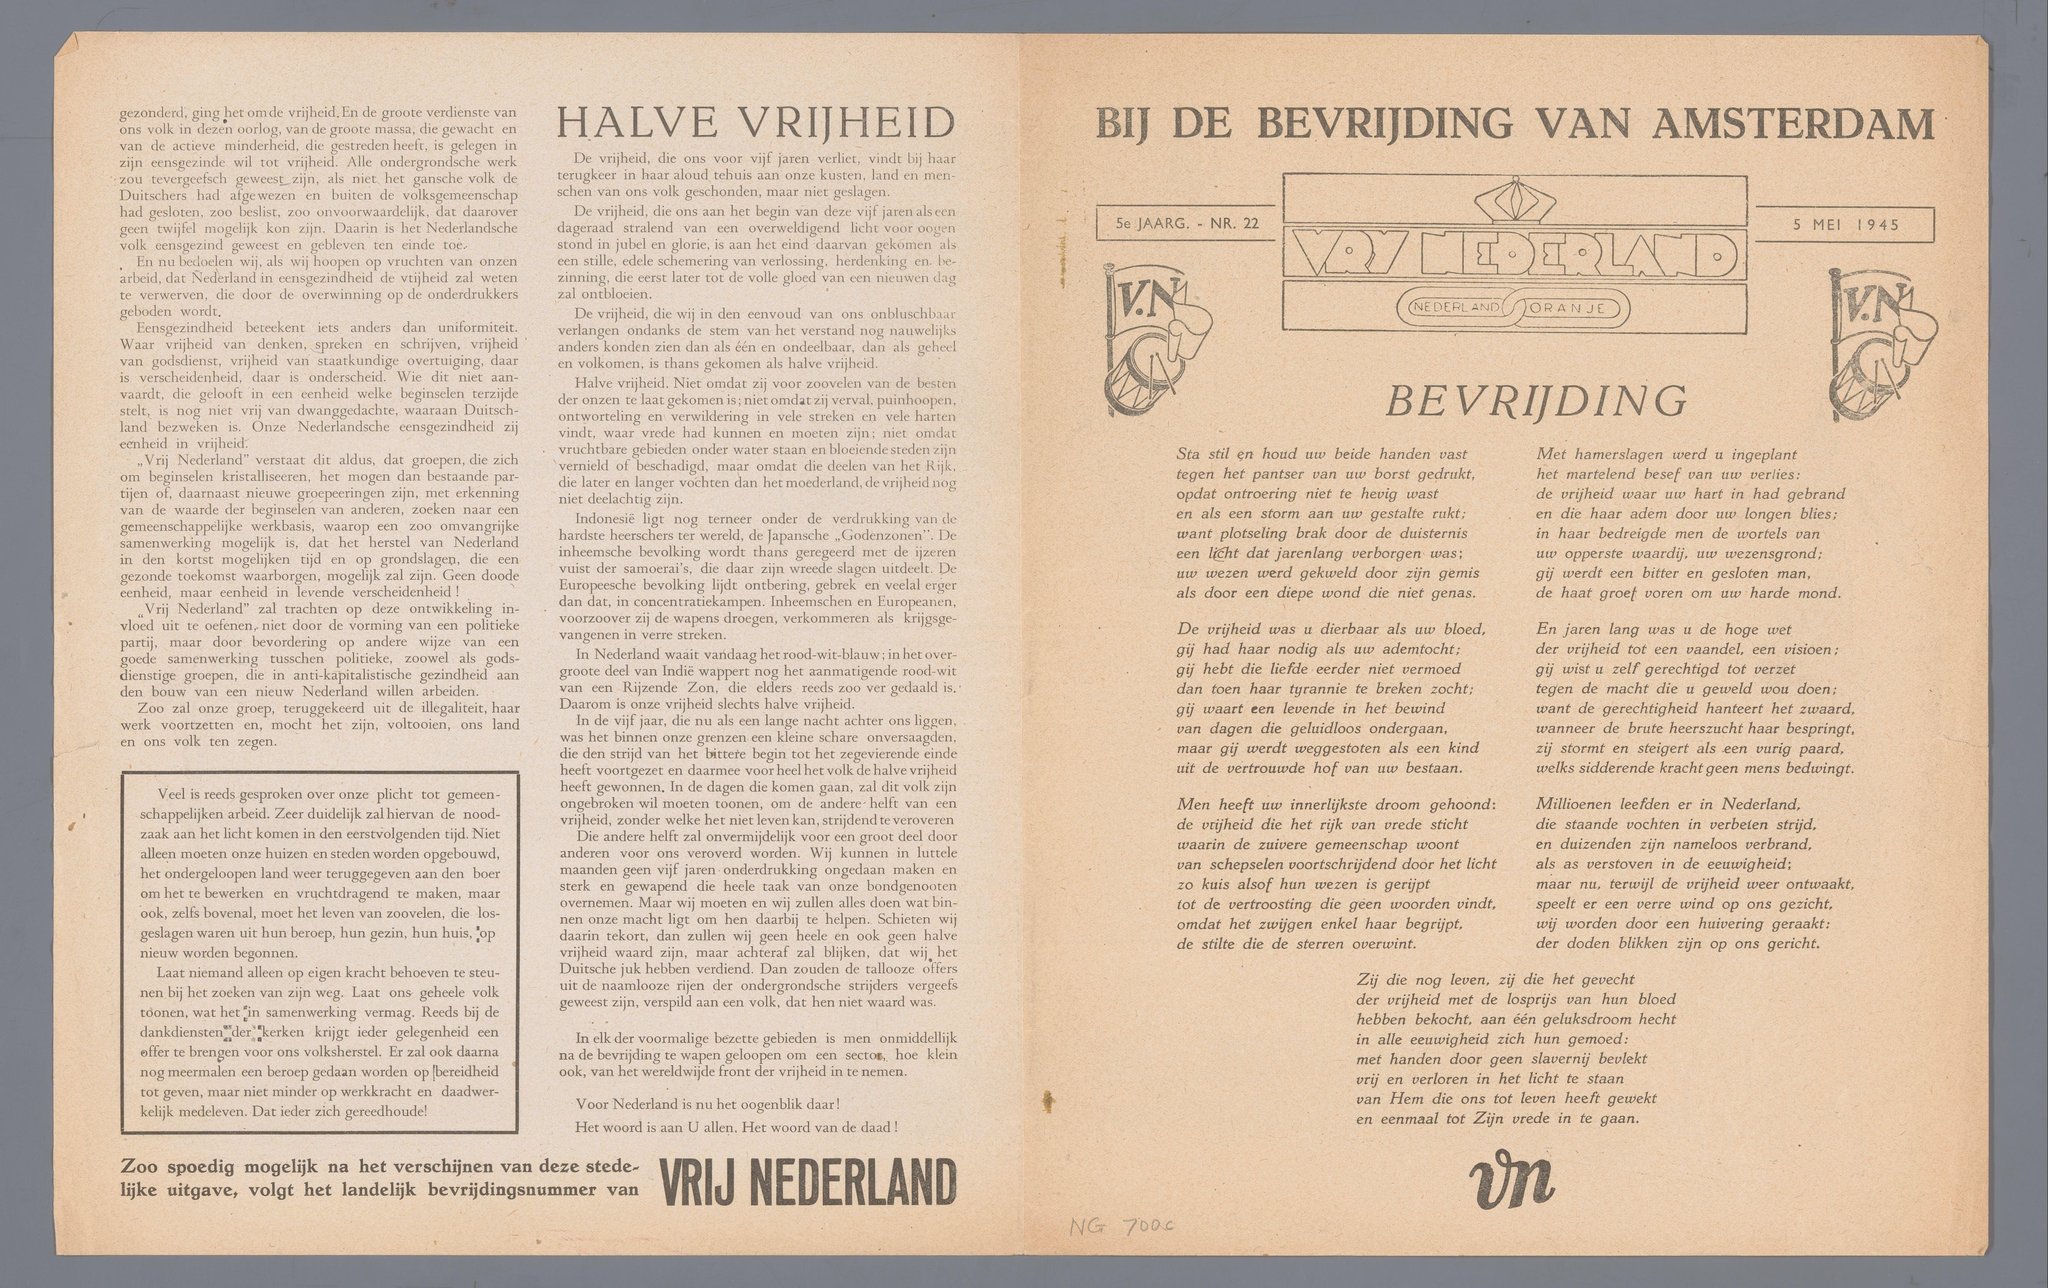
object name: newspaper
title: Vrij Nederland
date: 1945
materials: paper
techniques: printing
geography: amsterdam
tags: netherlands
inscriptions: date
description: Krant, nr. 22 van de 5e jaargang van het illegale blad 'Vrij Nederland', 4 pp. Opschrift; voorp.: 'Bevrijding'. Gedateerd: boven. Opmerking: Zie NG-700-B, D en E.